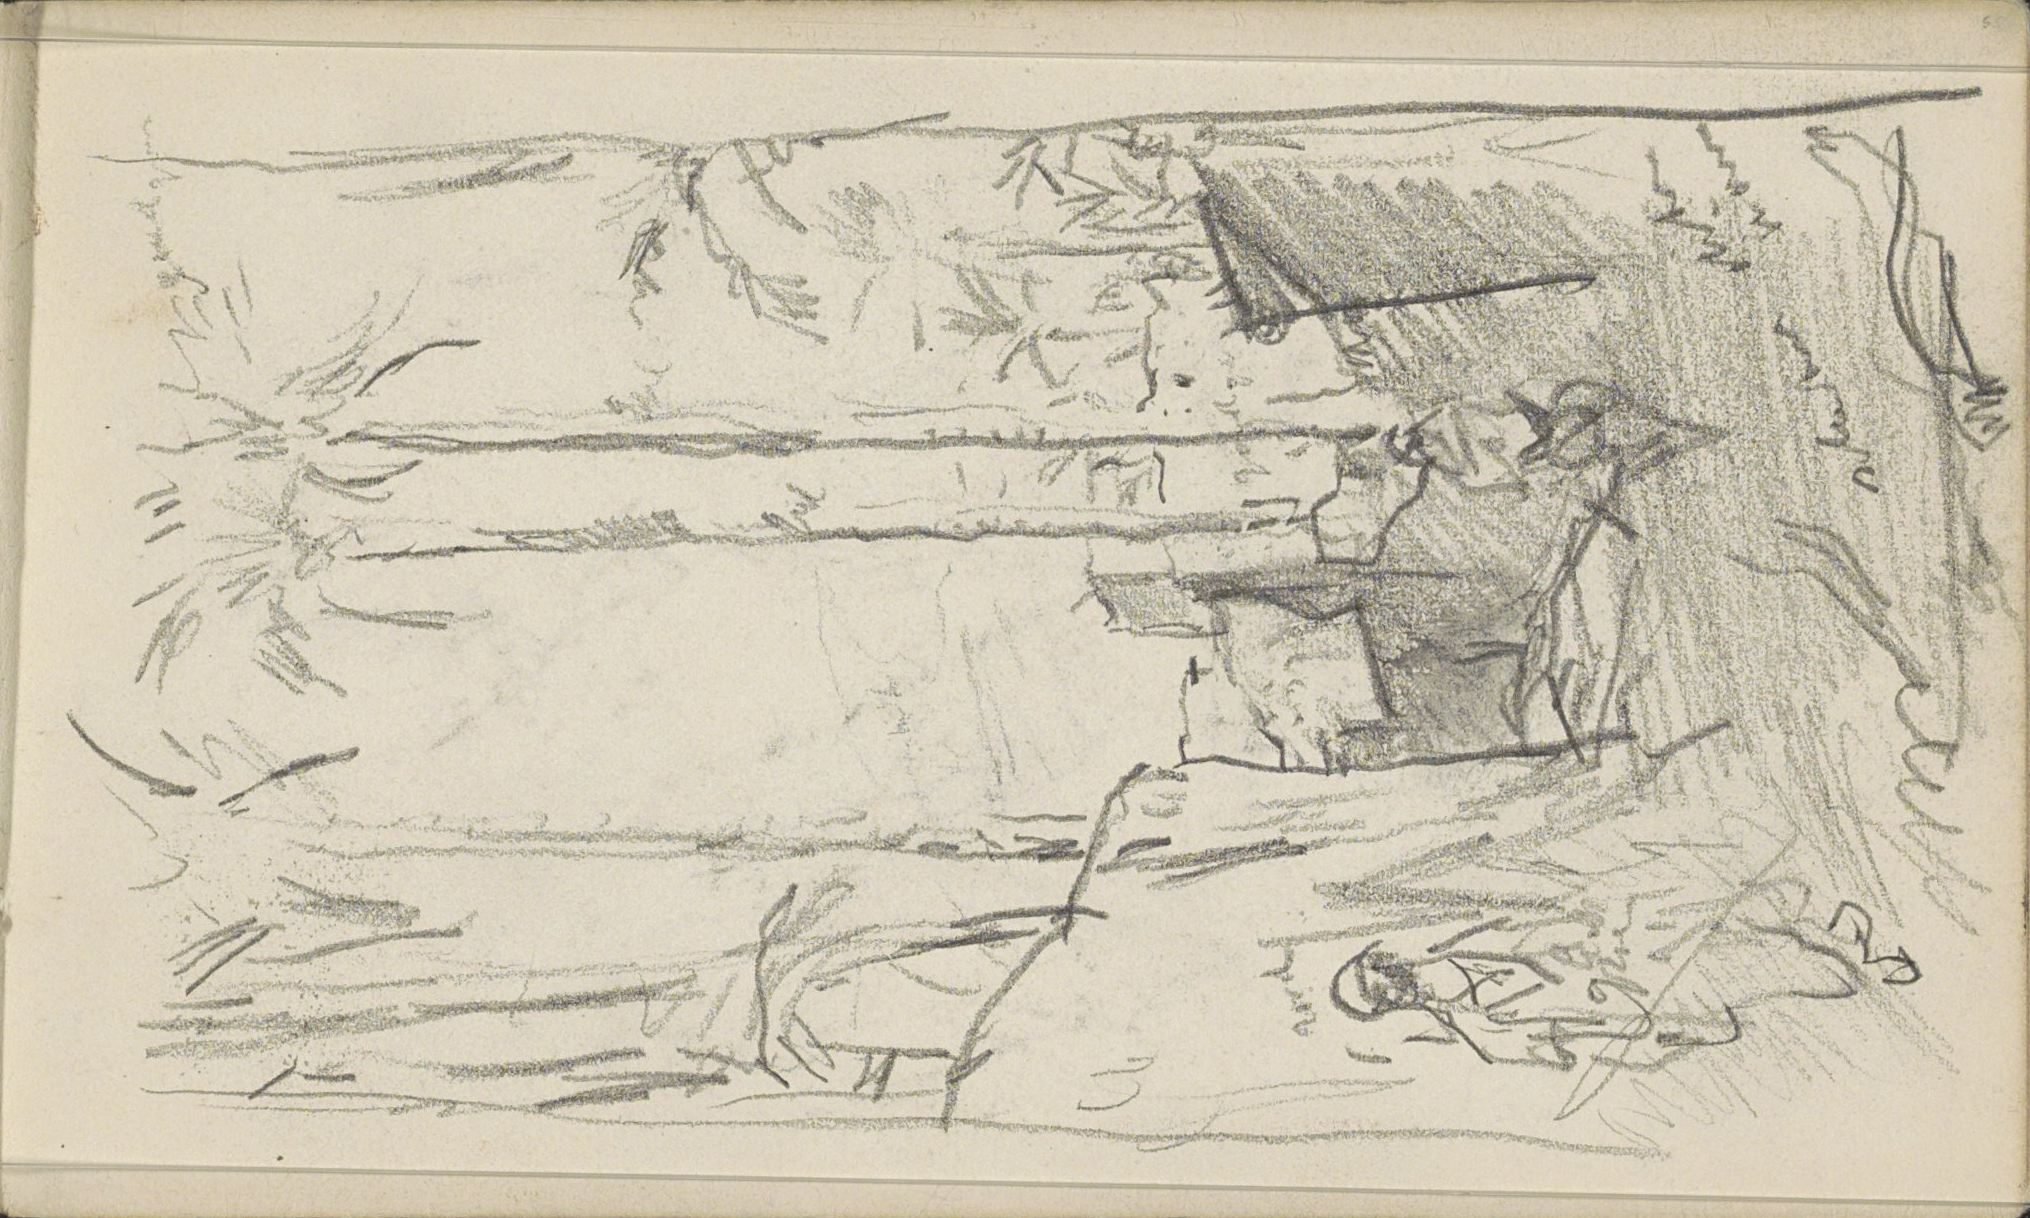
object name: sketchbook leaf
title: Straat met figuren en palmbomen in Biskra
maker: marius bauer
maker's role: draughtsman, print maker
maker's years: 1867-1932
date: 1922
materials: paper, pencil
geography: biskra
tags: trees: palm-tree, street (+ city(-scape) with figures, staffage)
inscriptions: kleurnotitie, handgeschreven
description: Pagina 55 uit een schetsboek met 31 bladen.